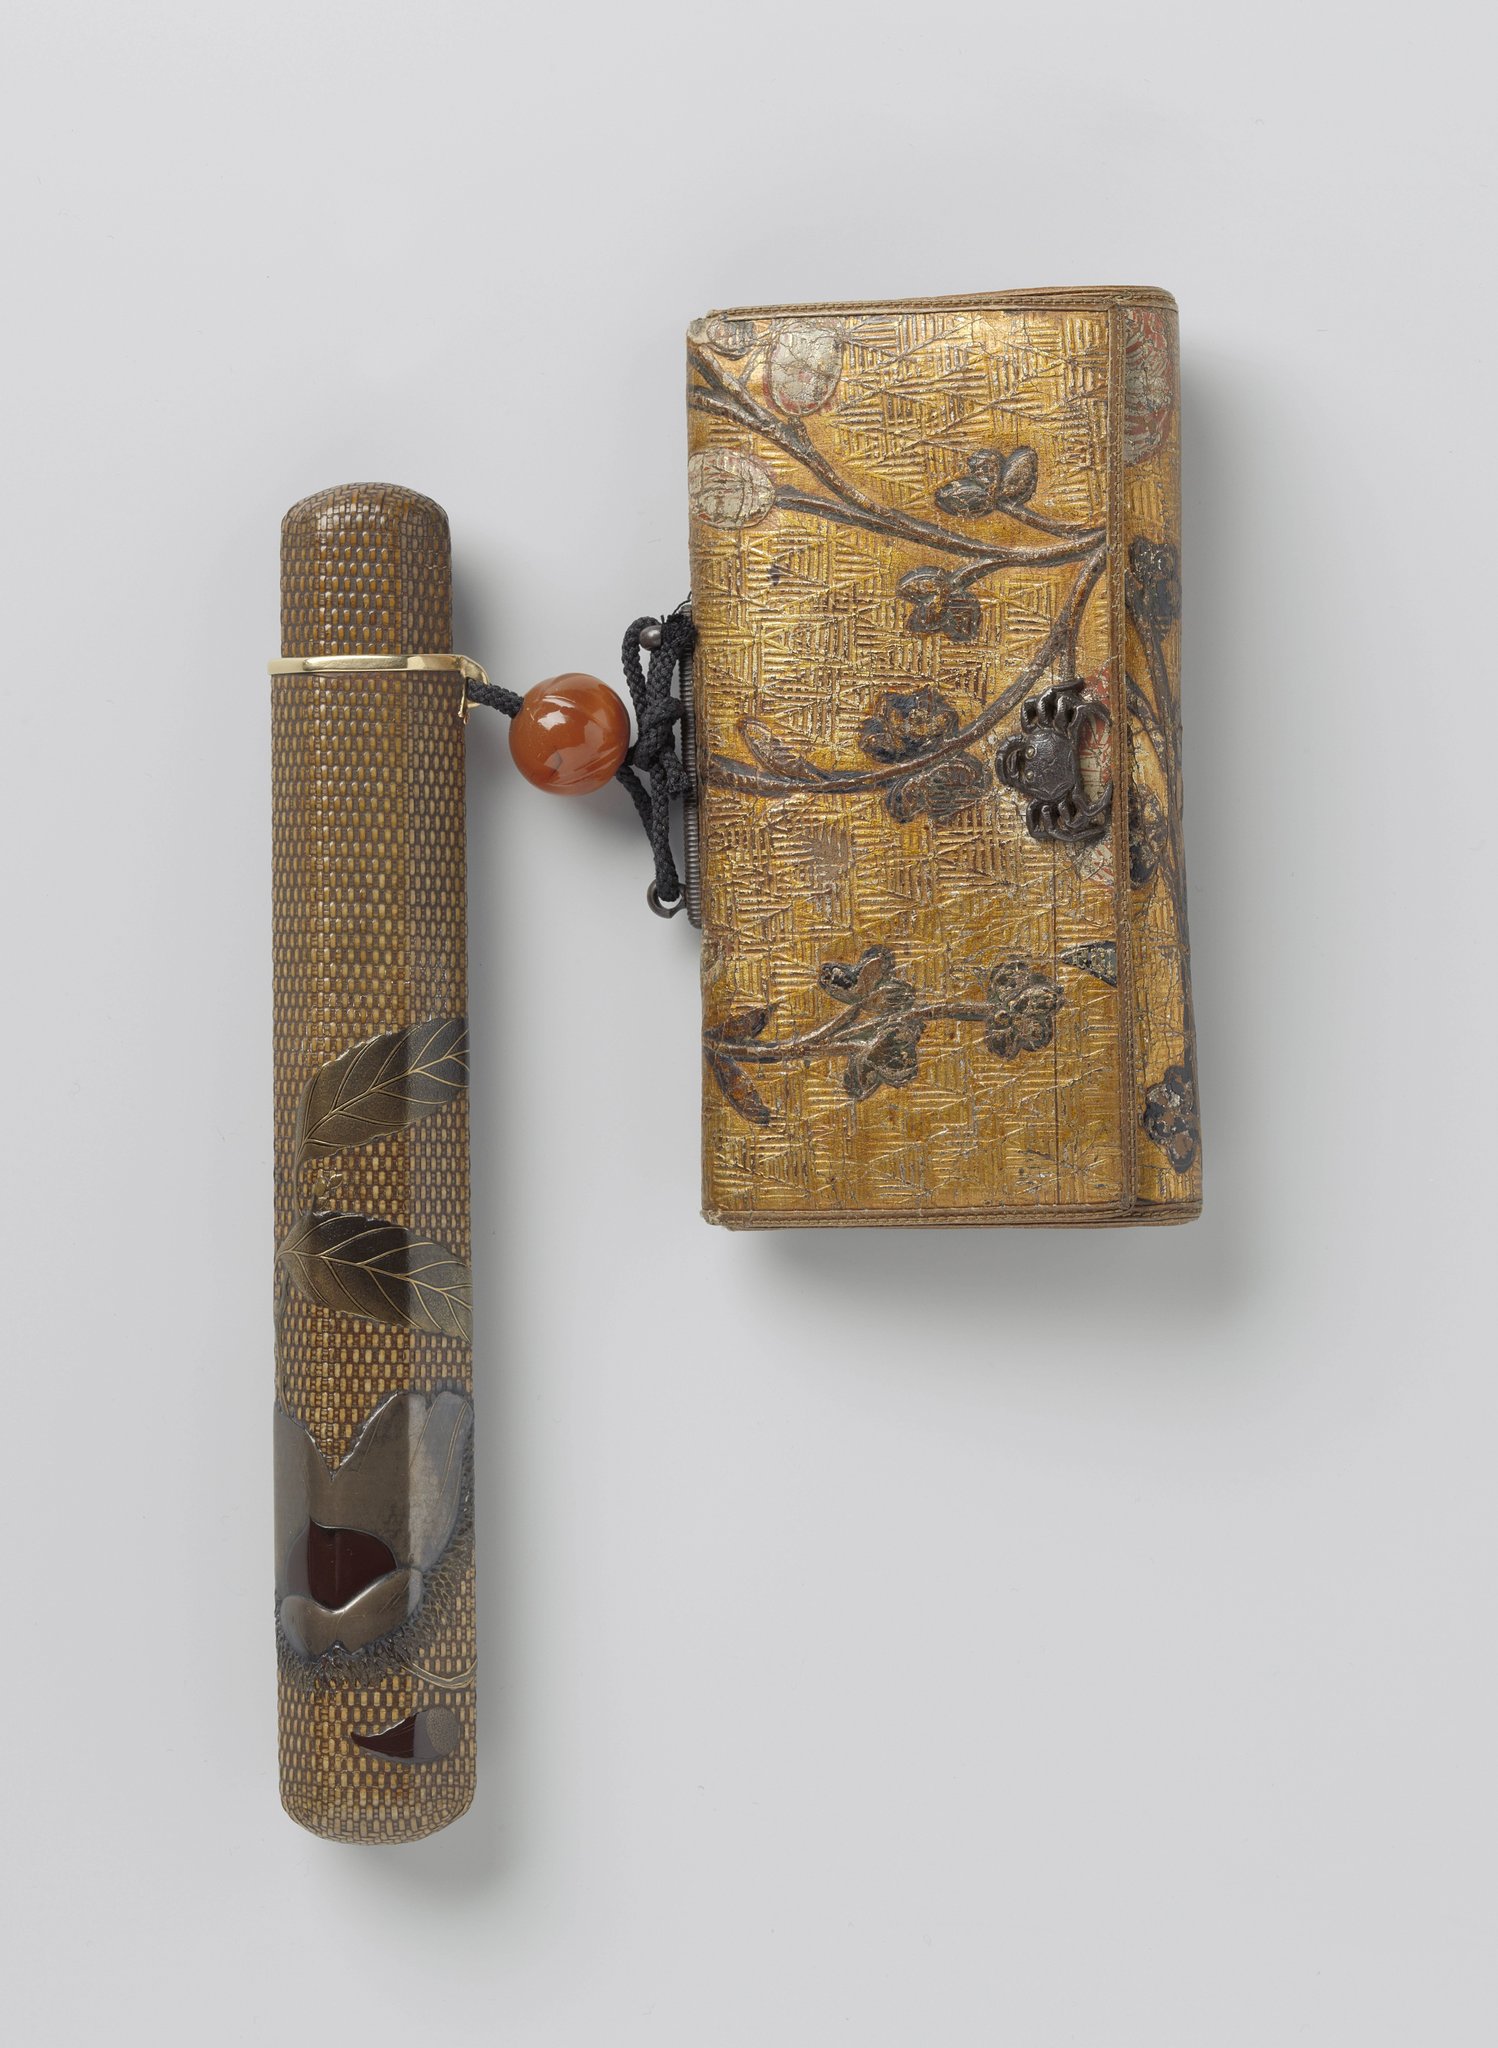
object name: pipe holder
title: Pipe case with chestnuts and gilt leather tobacco pouch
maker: tsuzuki kosai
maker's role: lacquerer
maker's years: 1875-1941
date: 1900-1925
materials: bamboo, gemstone, gold, iron, lacquer, paper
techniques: weave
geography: japan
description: This pipe case is made of woven rattan, the accompanying tobacco pouch of gilt leather, with a tiny crab as a press stud. The pipe case’s long, narrow format often inspired unusual designs. A burst chestnut husk lies on the ground. The length of the pipe case suggests how far the chestnut fell.